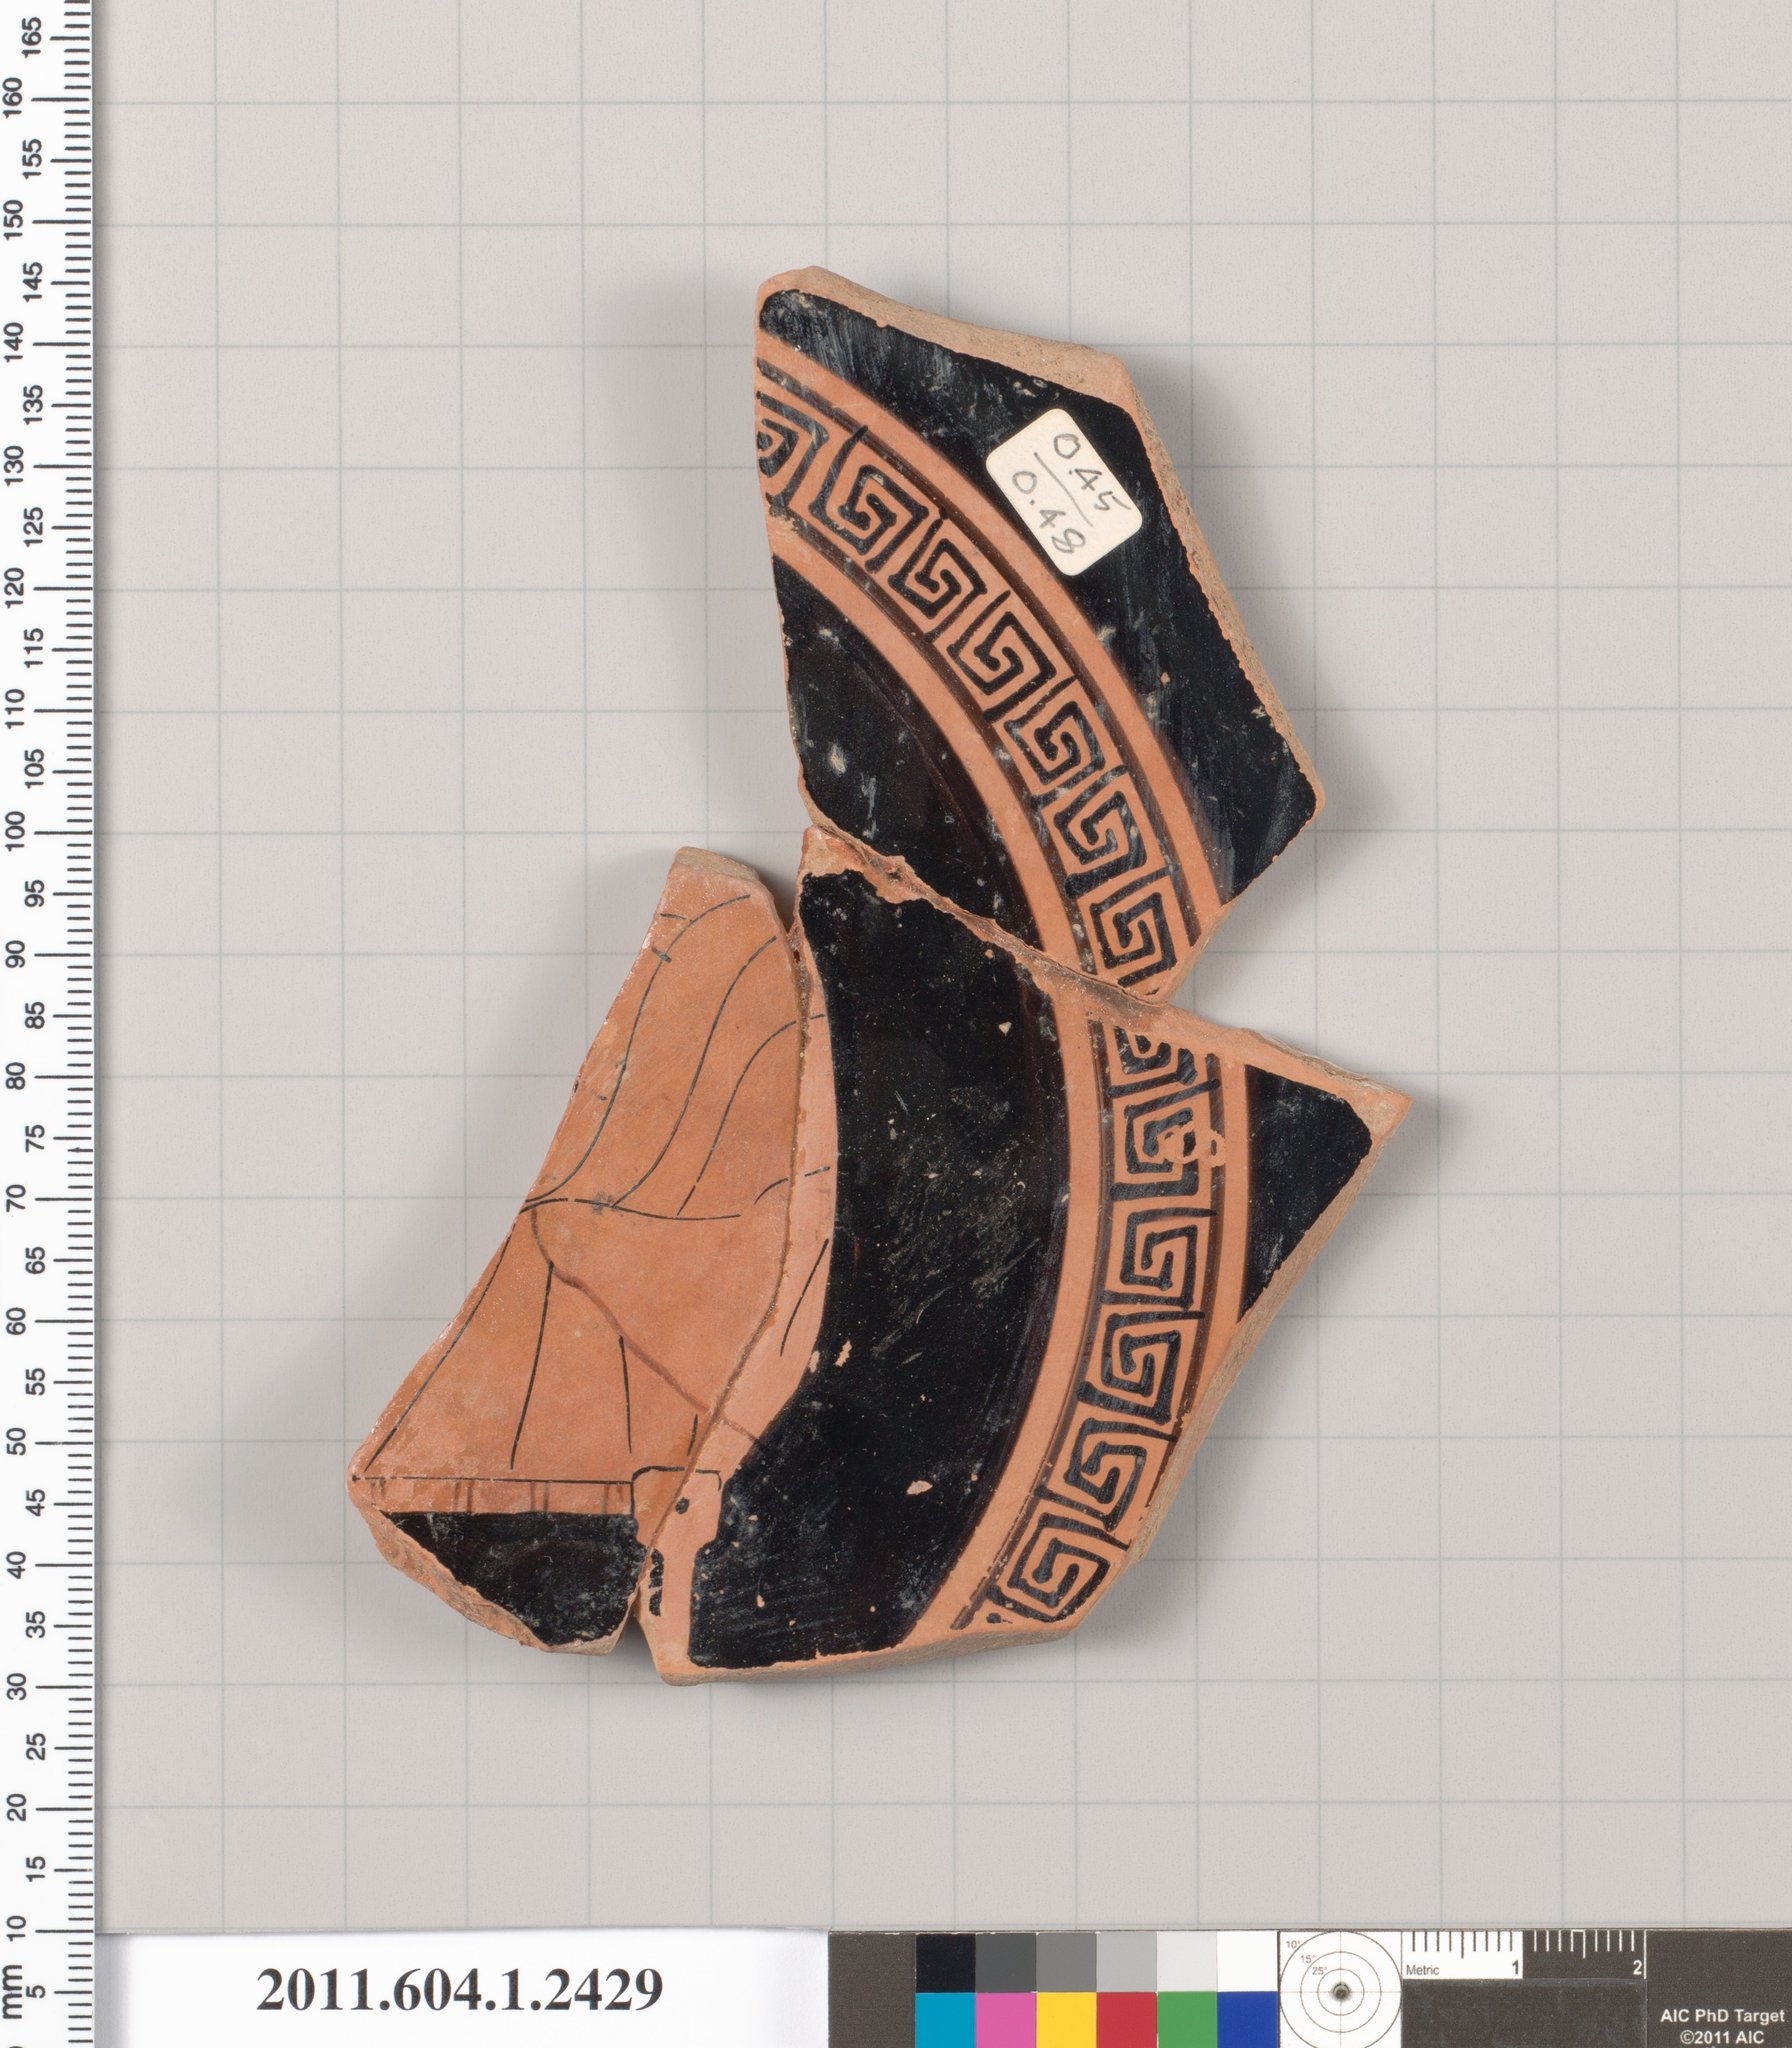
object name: kylix fragment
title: Terracotta fragment of a kylix (drinking cup)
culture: greek, attic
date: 475-451 BCE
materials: terracotta